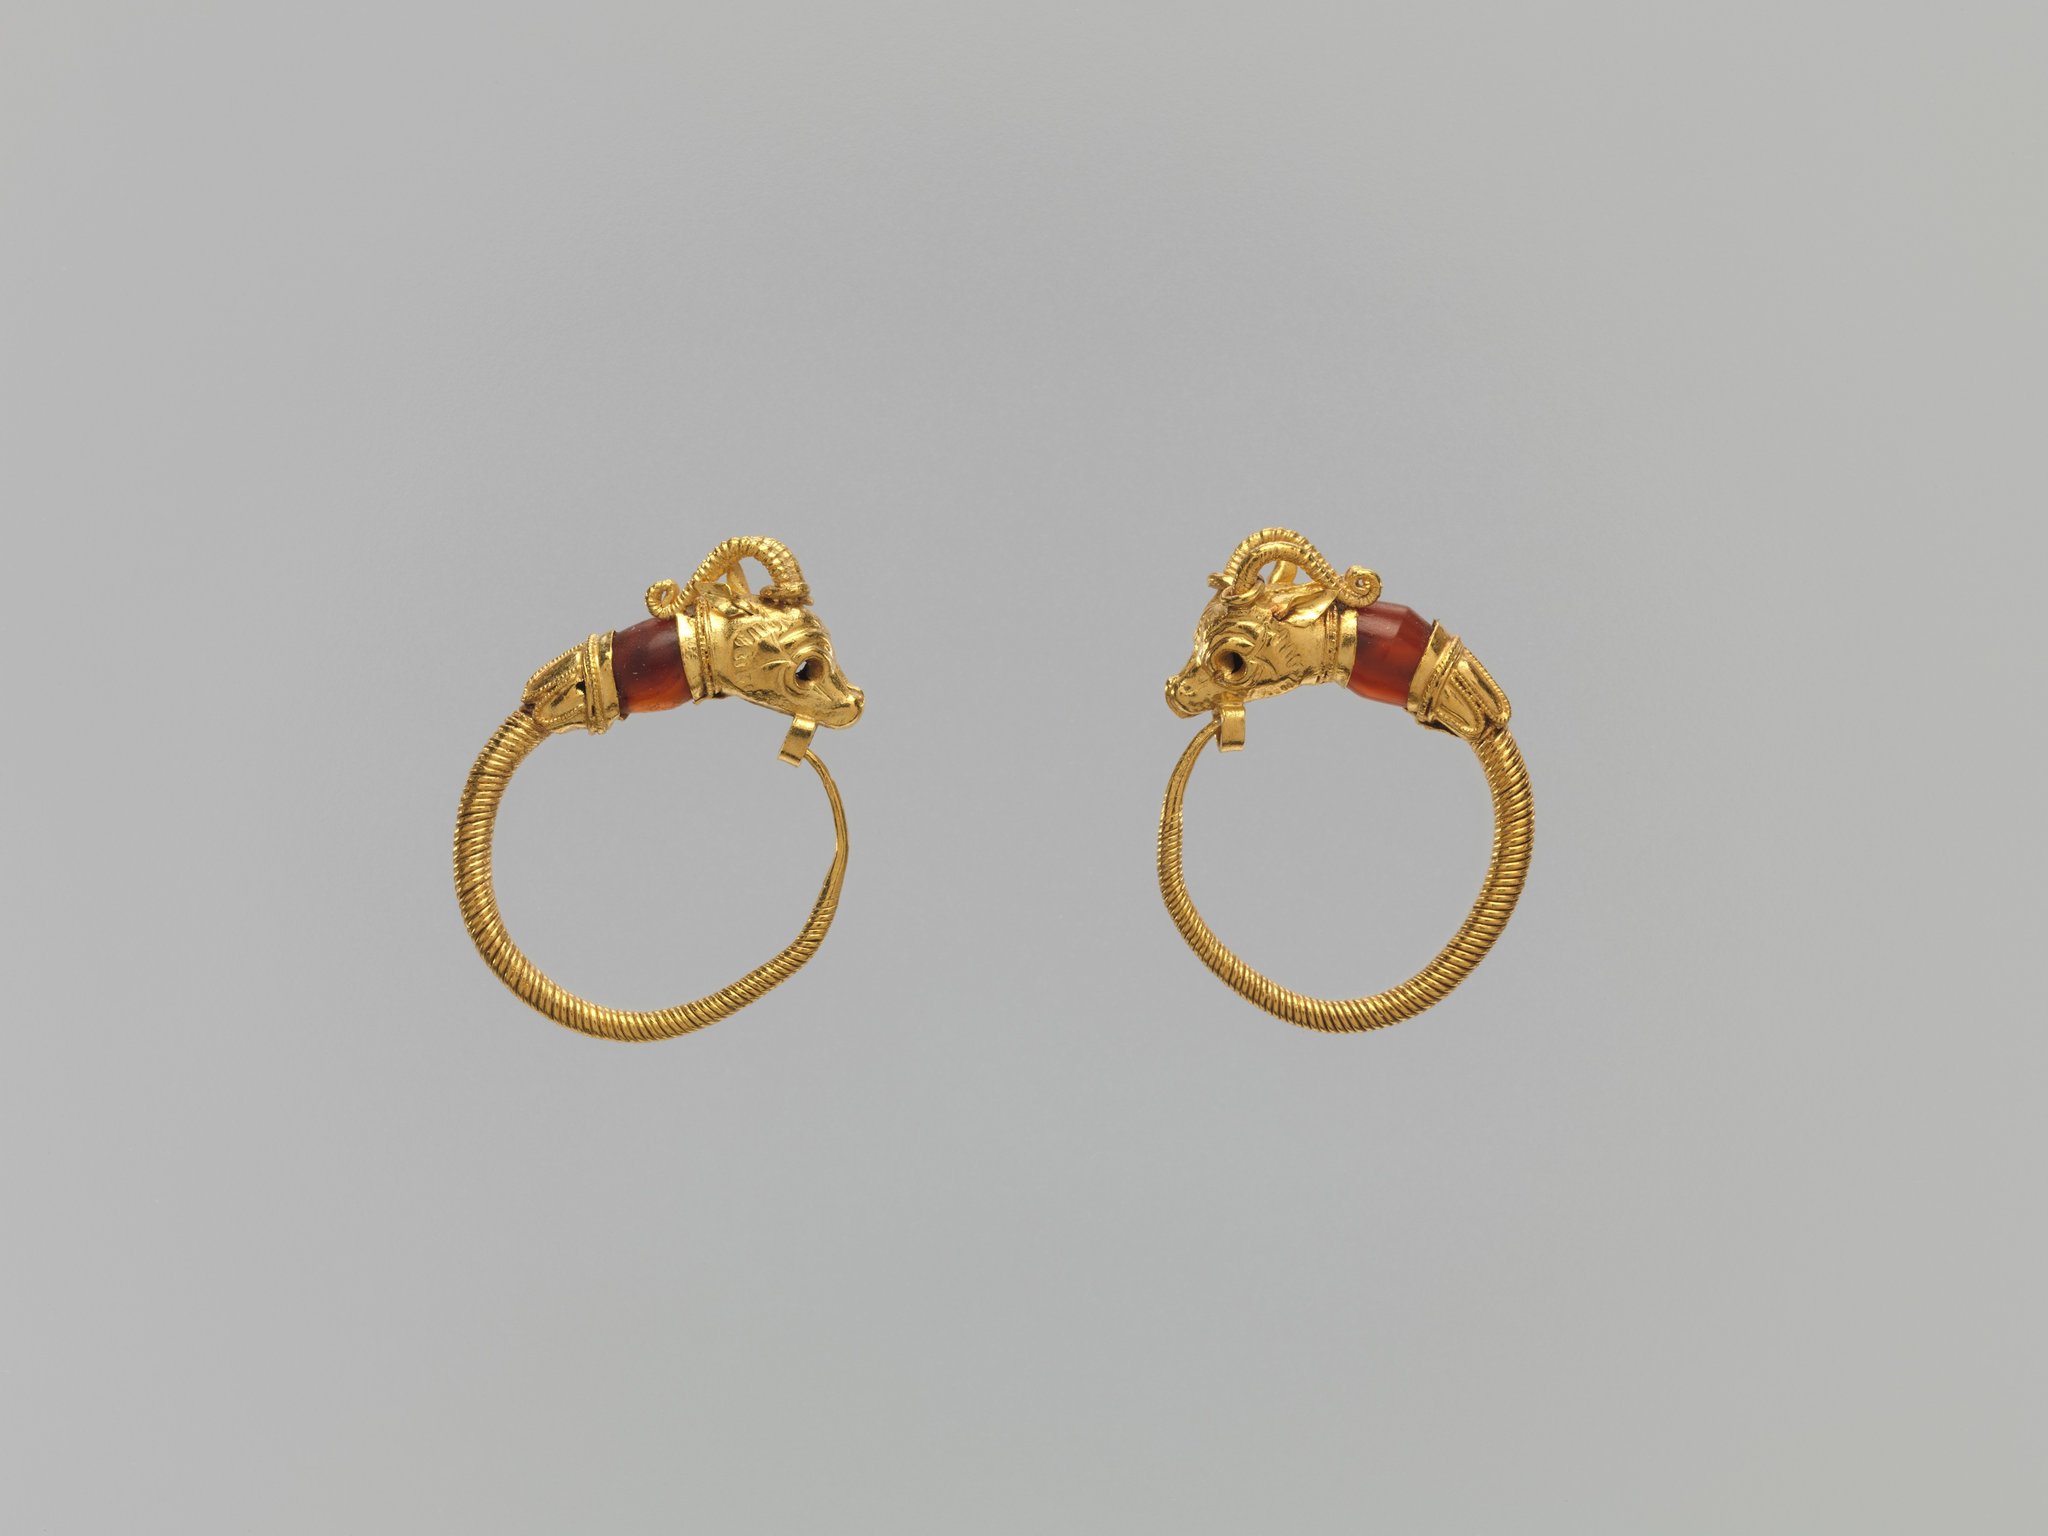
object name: earring, ibex head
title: Ibex-head earrings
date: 200-1 BCE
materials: gemstone, gold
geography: egypt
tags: ibex